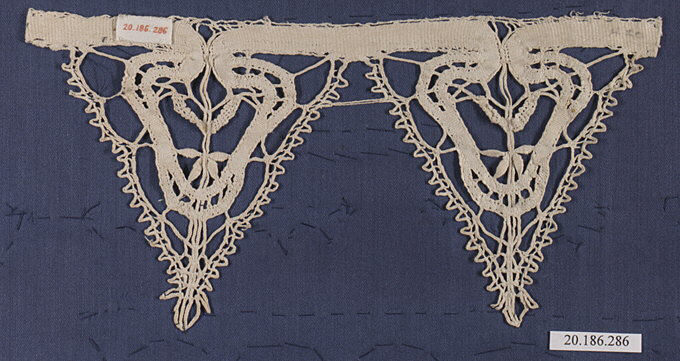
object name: edging fragment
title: Fragment of edging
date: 1601-1700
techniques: lace